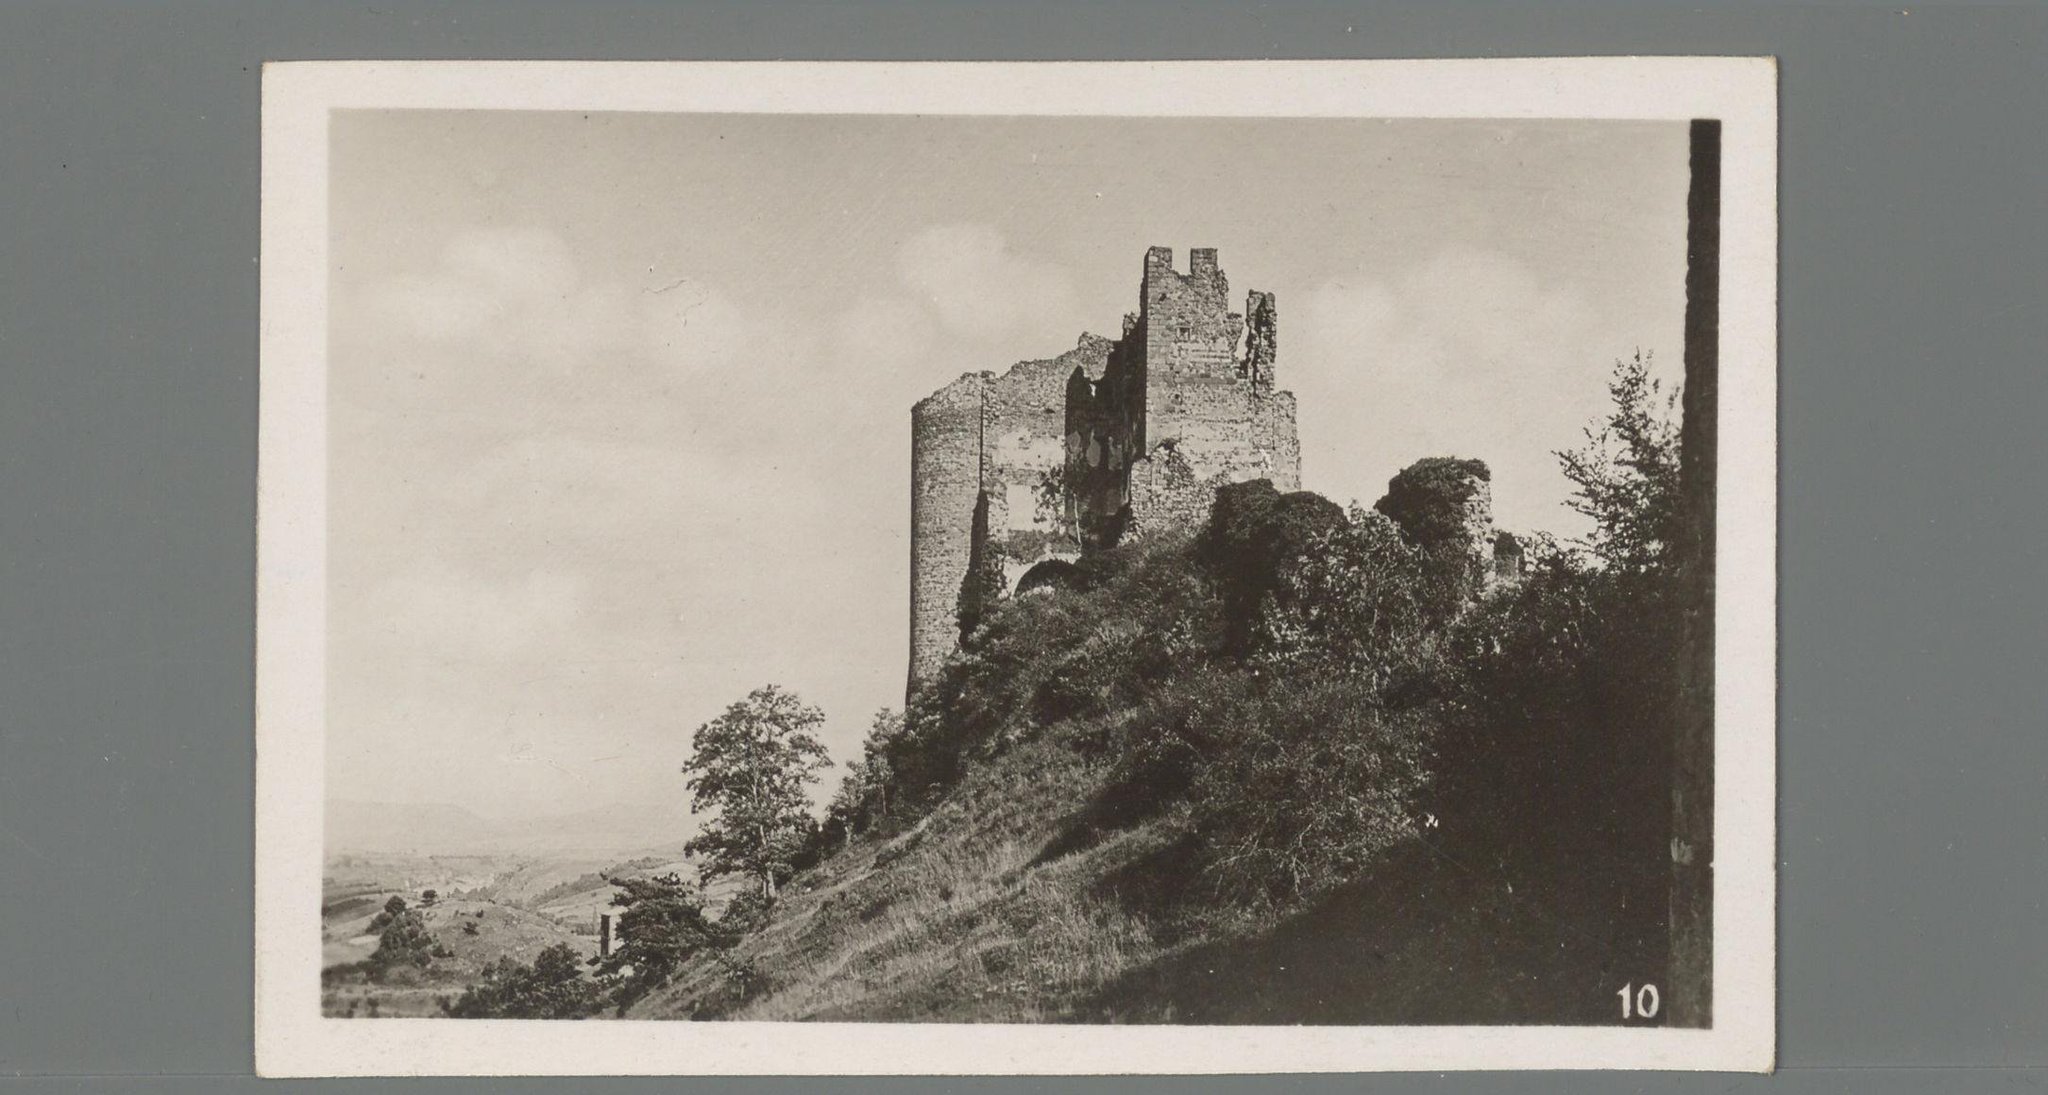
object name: photograph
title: Montaigut-le-Blanc. Le château, vue extérieur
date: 1920-1932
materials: photographic support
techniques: photography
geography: auvergne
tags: castle, (high) hill